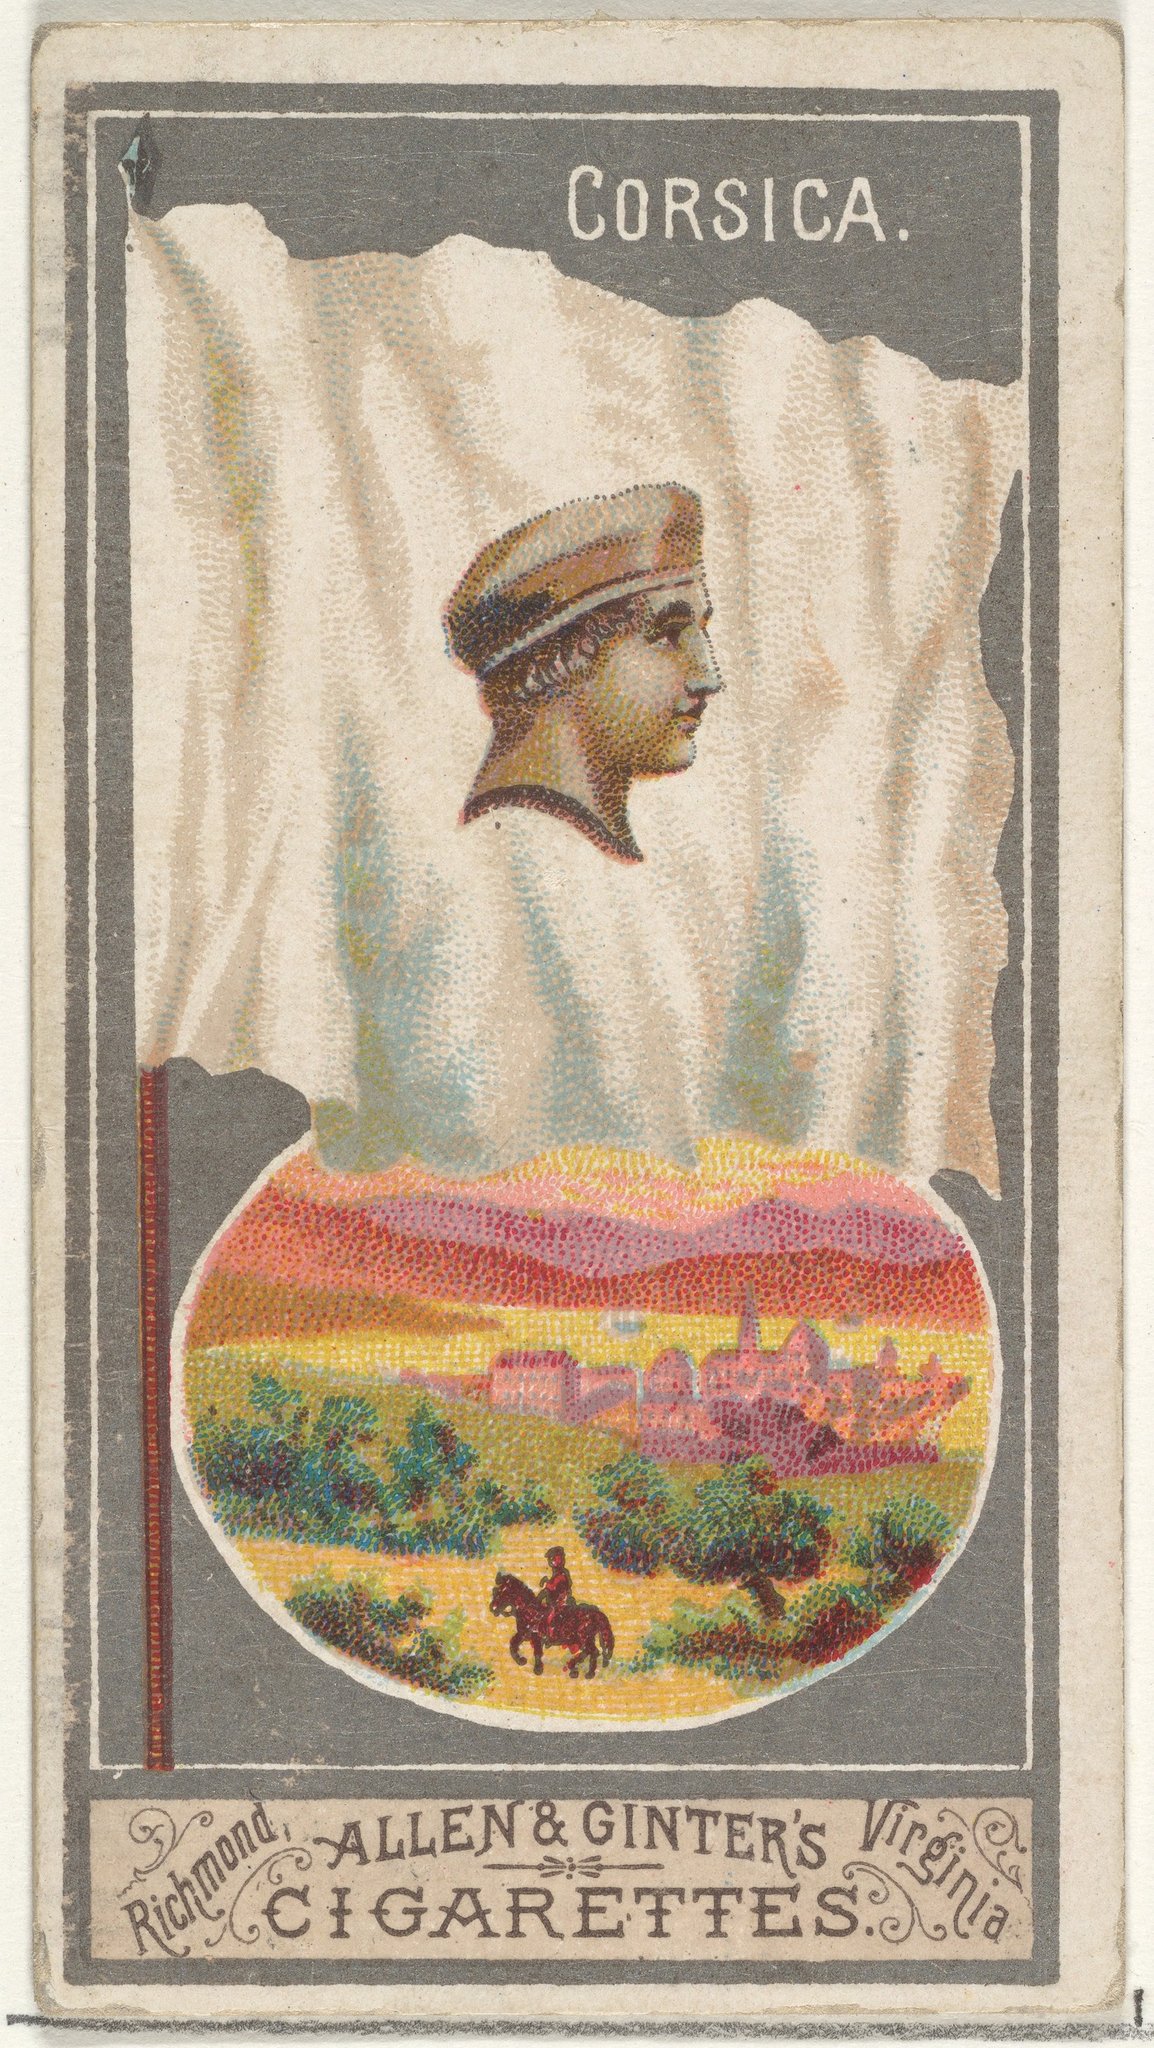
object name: print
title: Corsica, from the City Flags series (N6) for Allen & Ginter Cigarettes Brands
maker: allen & ginter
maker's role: publisher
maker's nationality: american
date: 1887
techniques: color lithograph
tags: flags